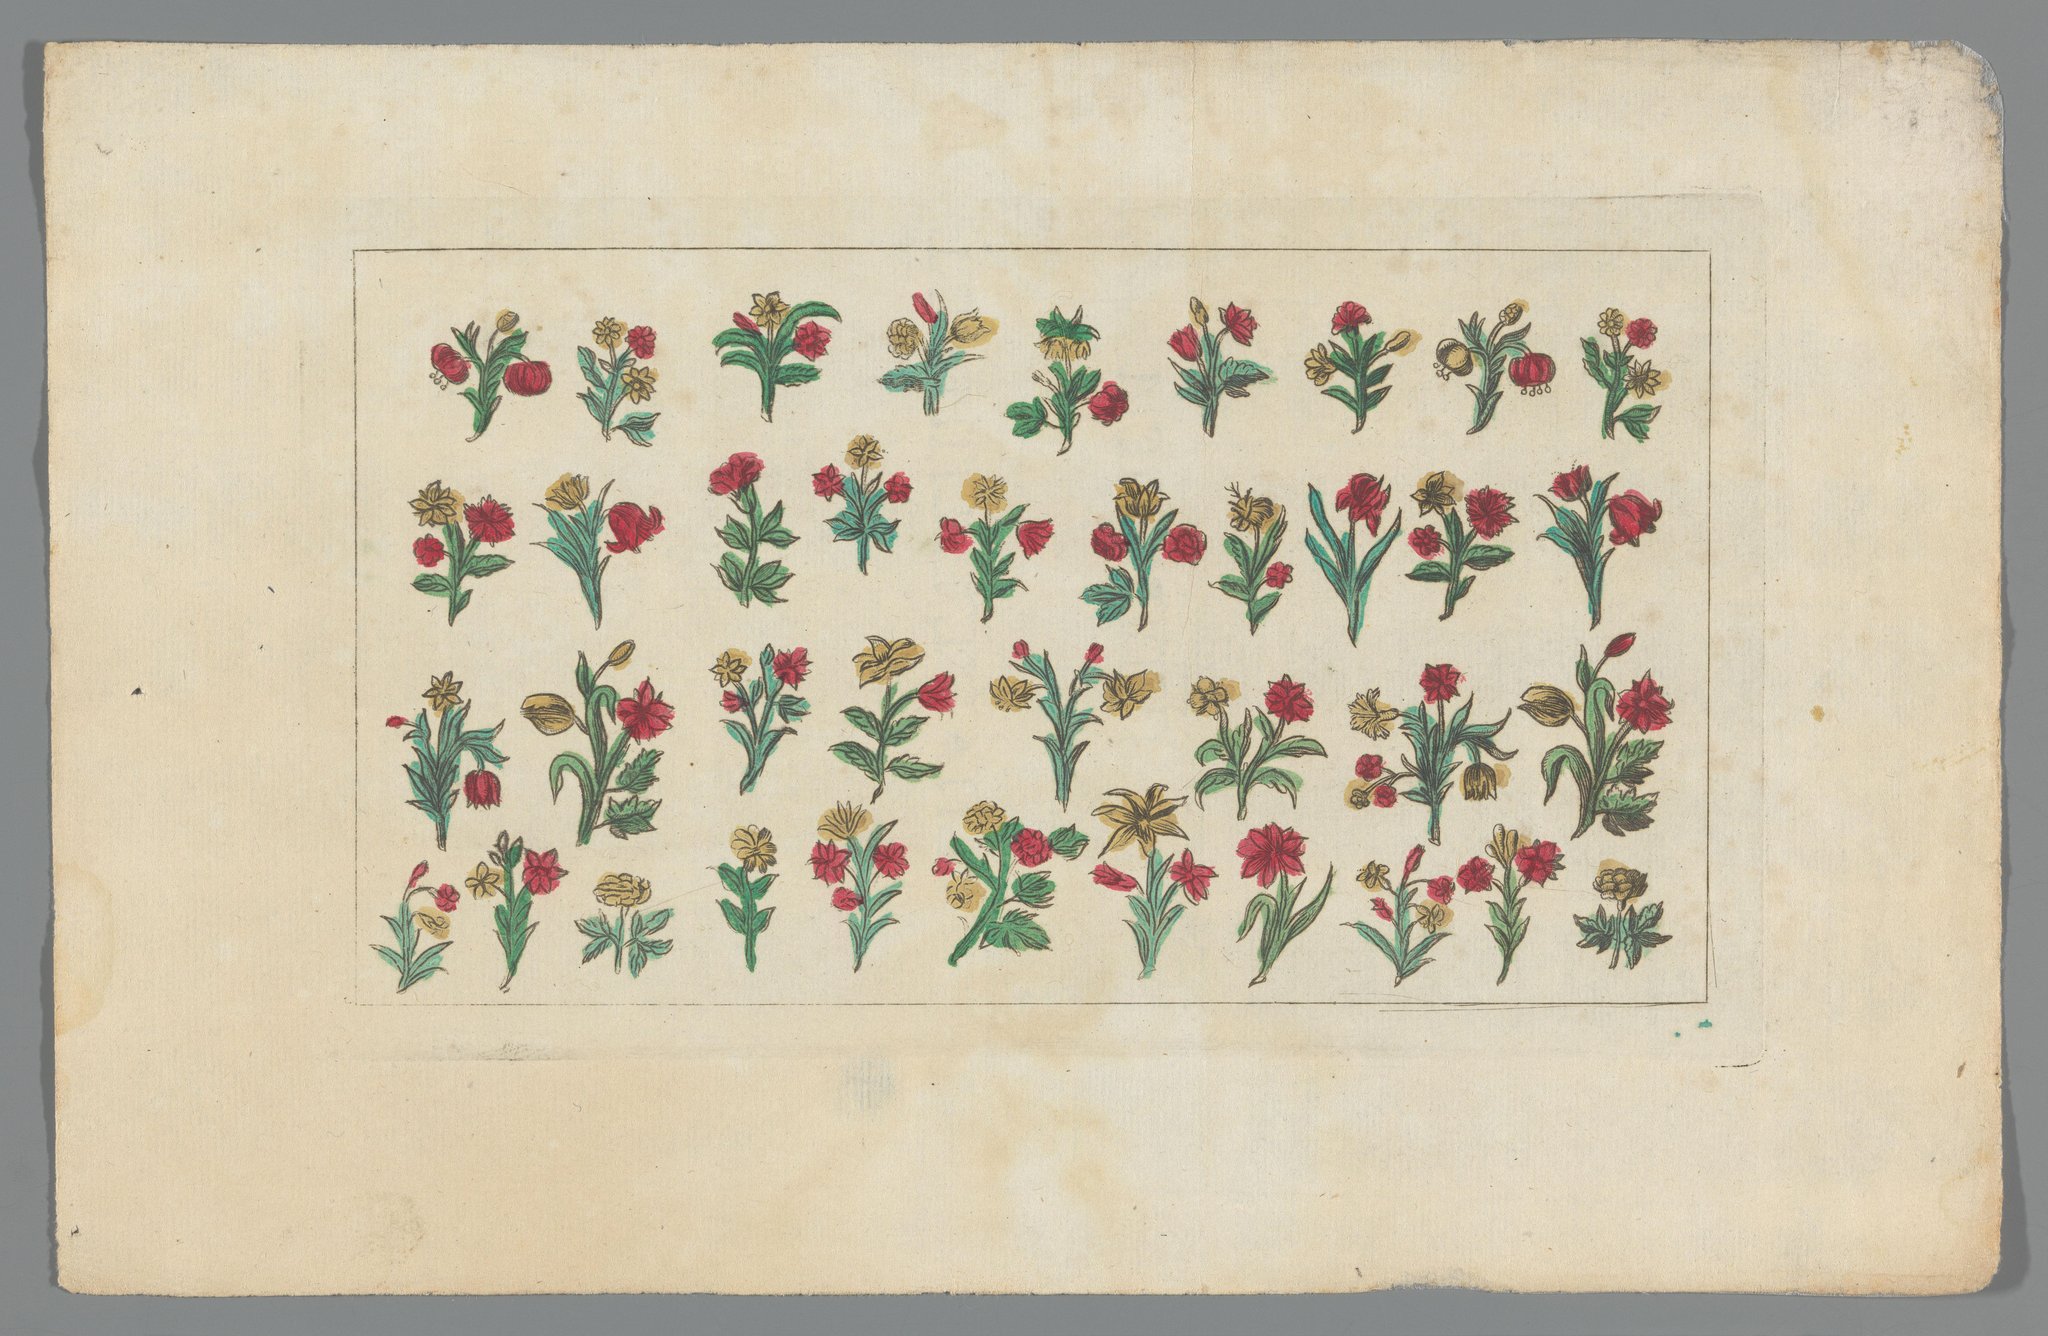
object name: print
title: Bladen met knipplaatjes en decoratieve randen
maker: Anonymous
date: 1750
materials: paper, watercolor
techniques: etching, hand coloring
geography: paris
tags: flowers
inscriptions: collector's mark: Lugt 2228, collector's mark: Lugt 2760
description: Blad met vier rijen bloemen. Een van 39 bladen met knipplaatjes en decoratieve randen.